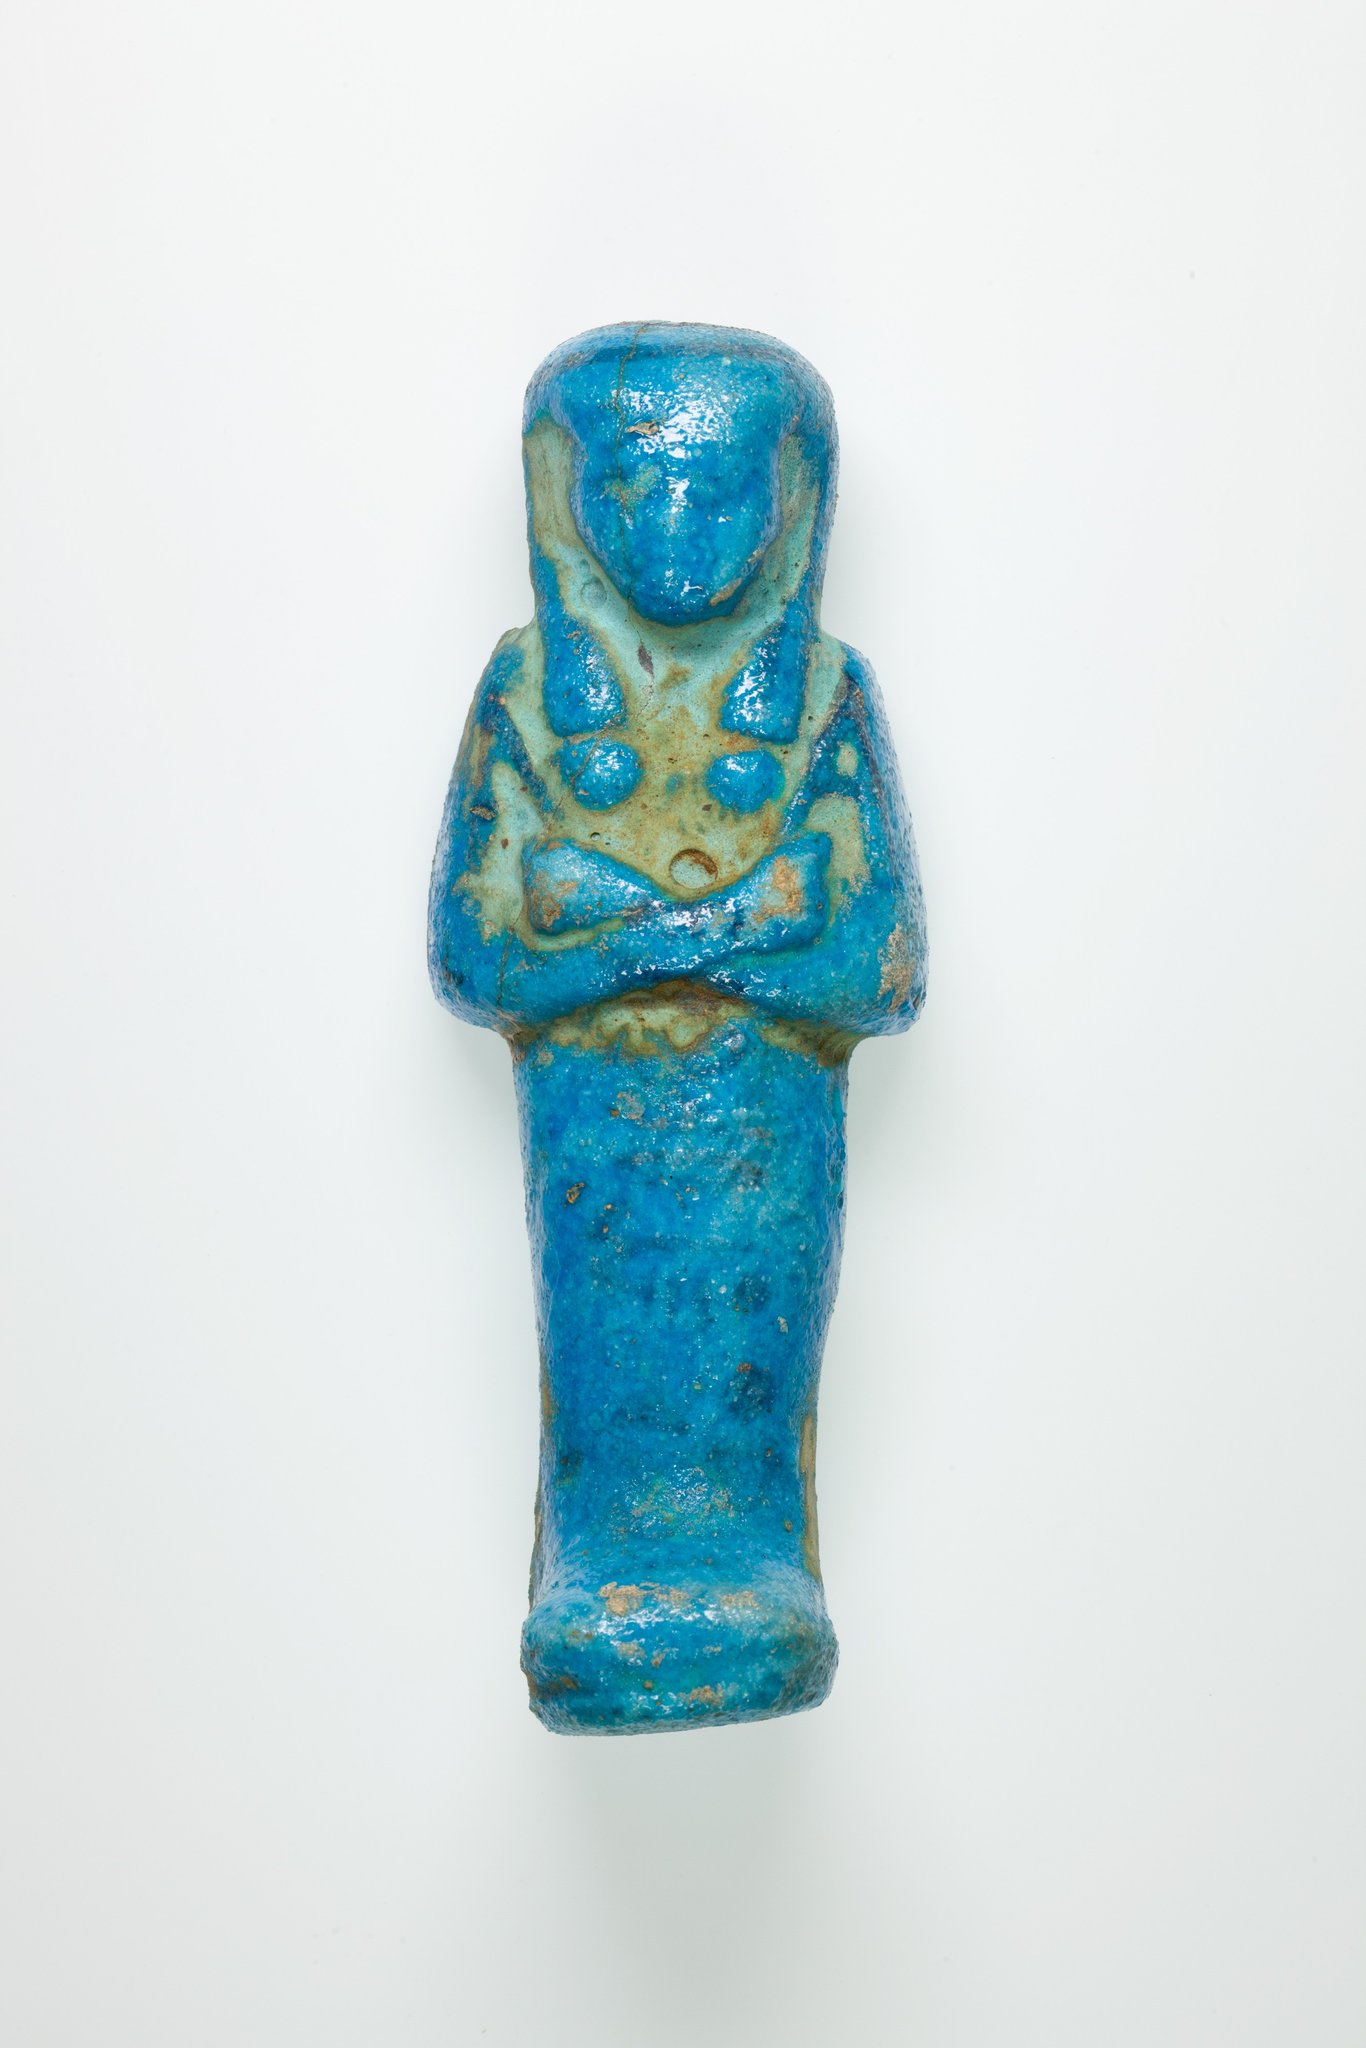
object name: worker shabti, henettawy c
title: Worker Shabti of Henettawy (C), Daughter of Isetemkheb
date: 990-970 BCE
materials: faience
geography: egypt